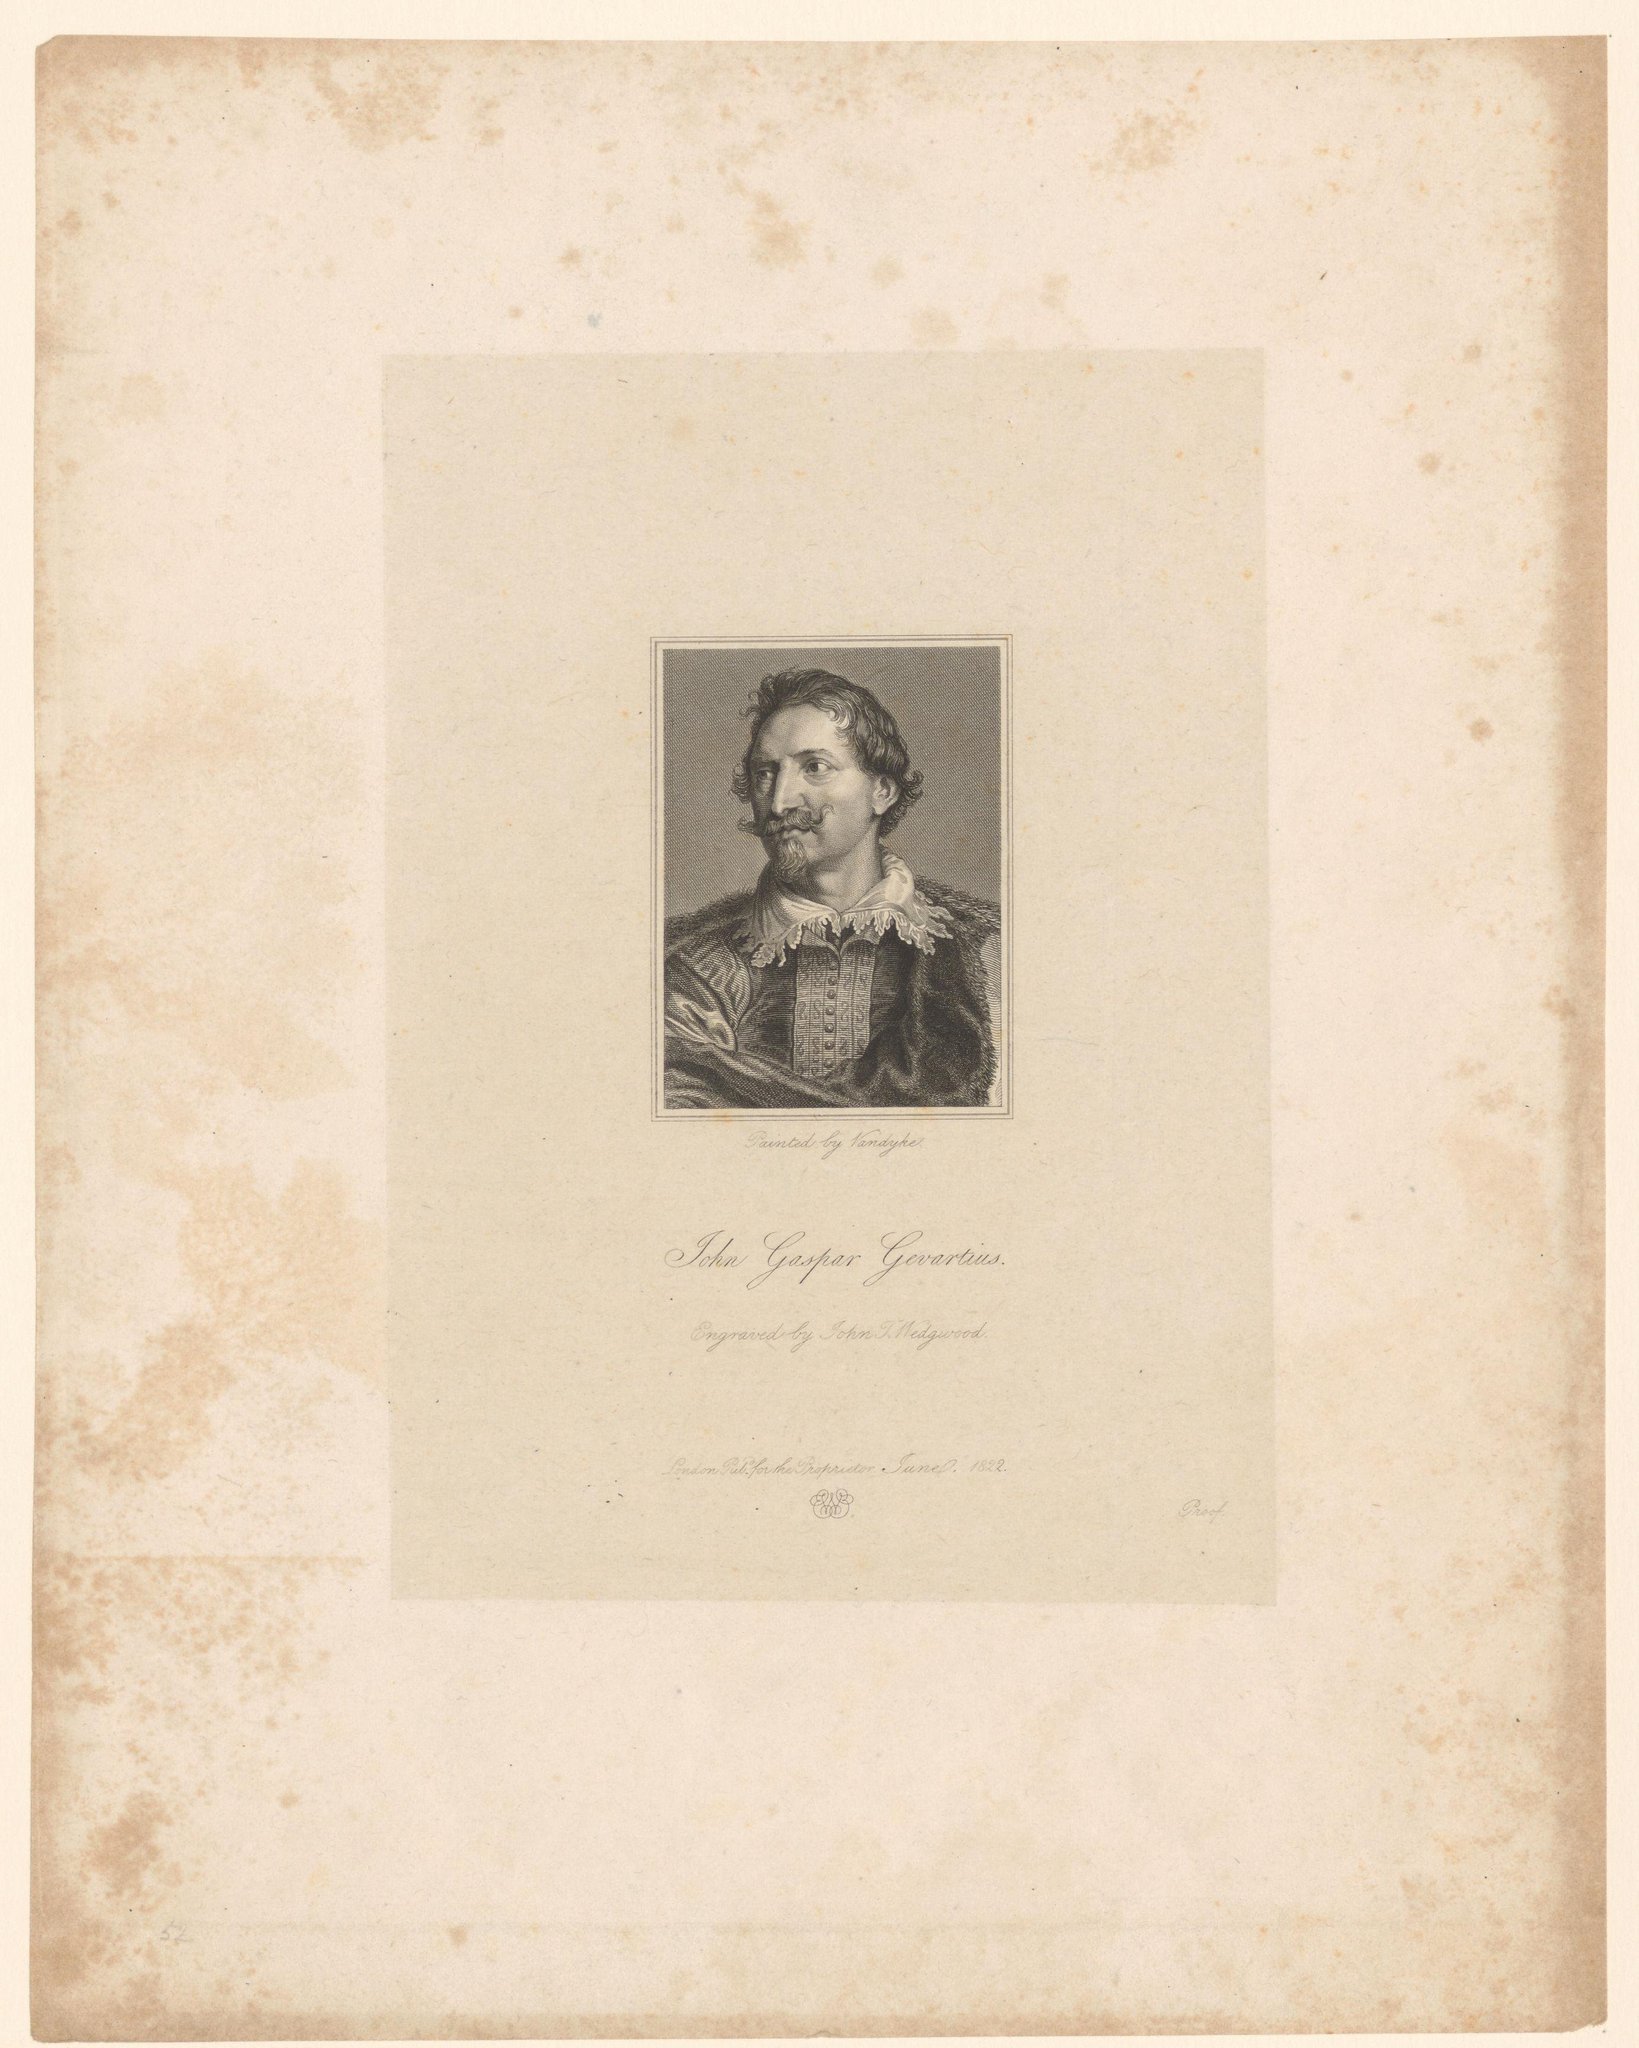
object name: print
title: John Gaspar Gevartius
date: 1806-1822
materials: paper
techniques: engraving, etching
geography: london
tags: antwerp, politician, jean gaspard gevartius, historical persons, magistracy, judges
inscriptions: collector's mark: Lugt 2228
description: Tweede staat gebruikt in: Walmsley, Edward. Physiognomical portraits, one hundred distinguished characters (...). Londen: John Major, Robert Jennings et al., 1822, dl. 1.